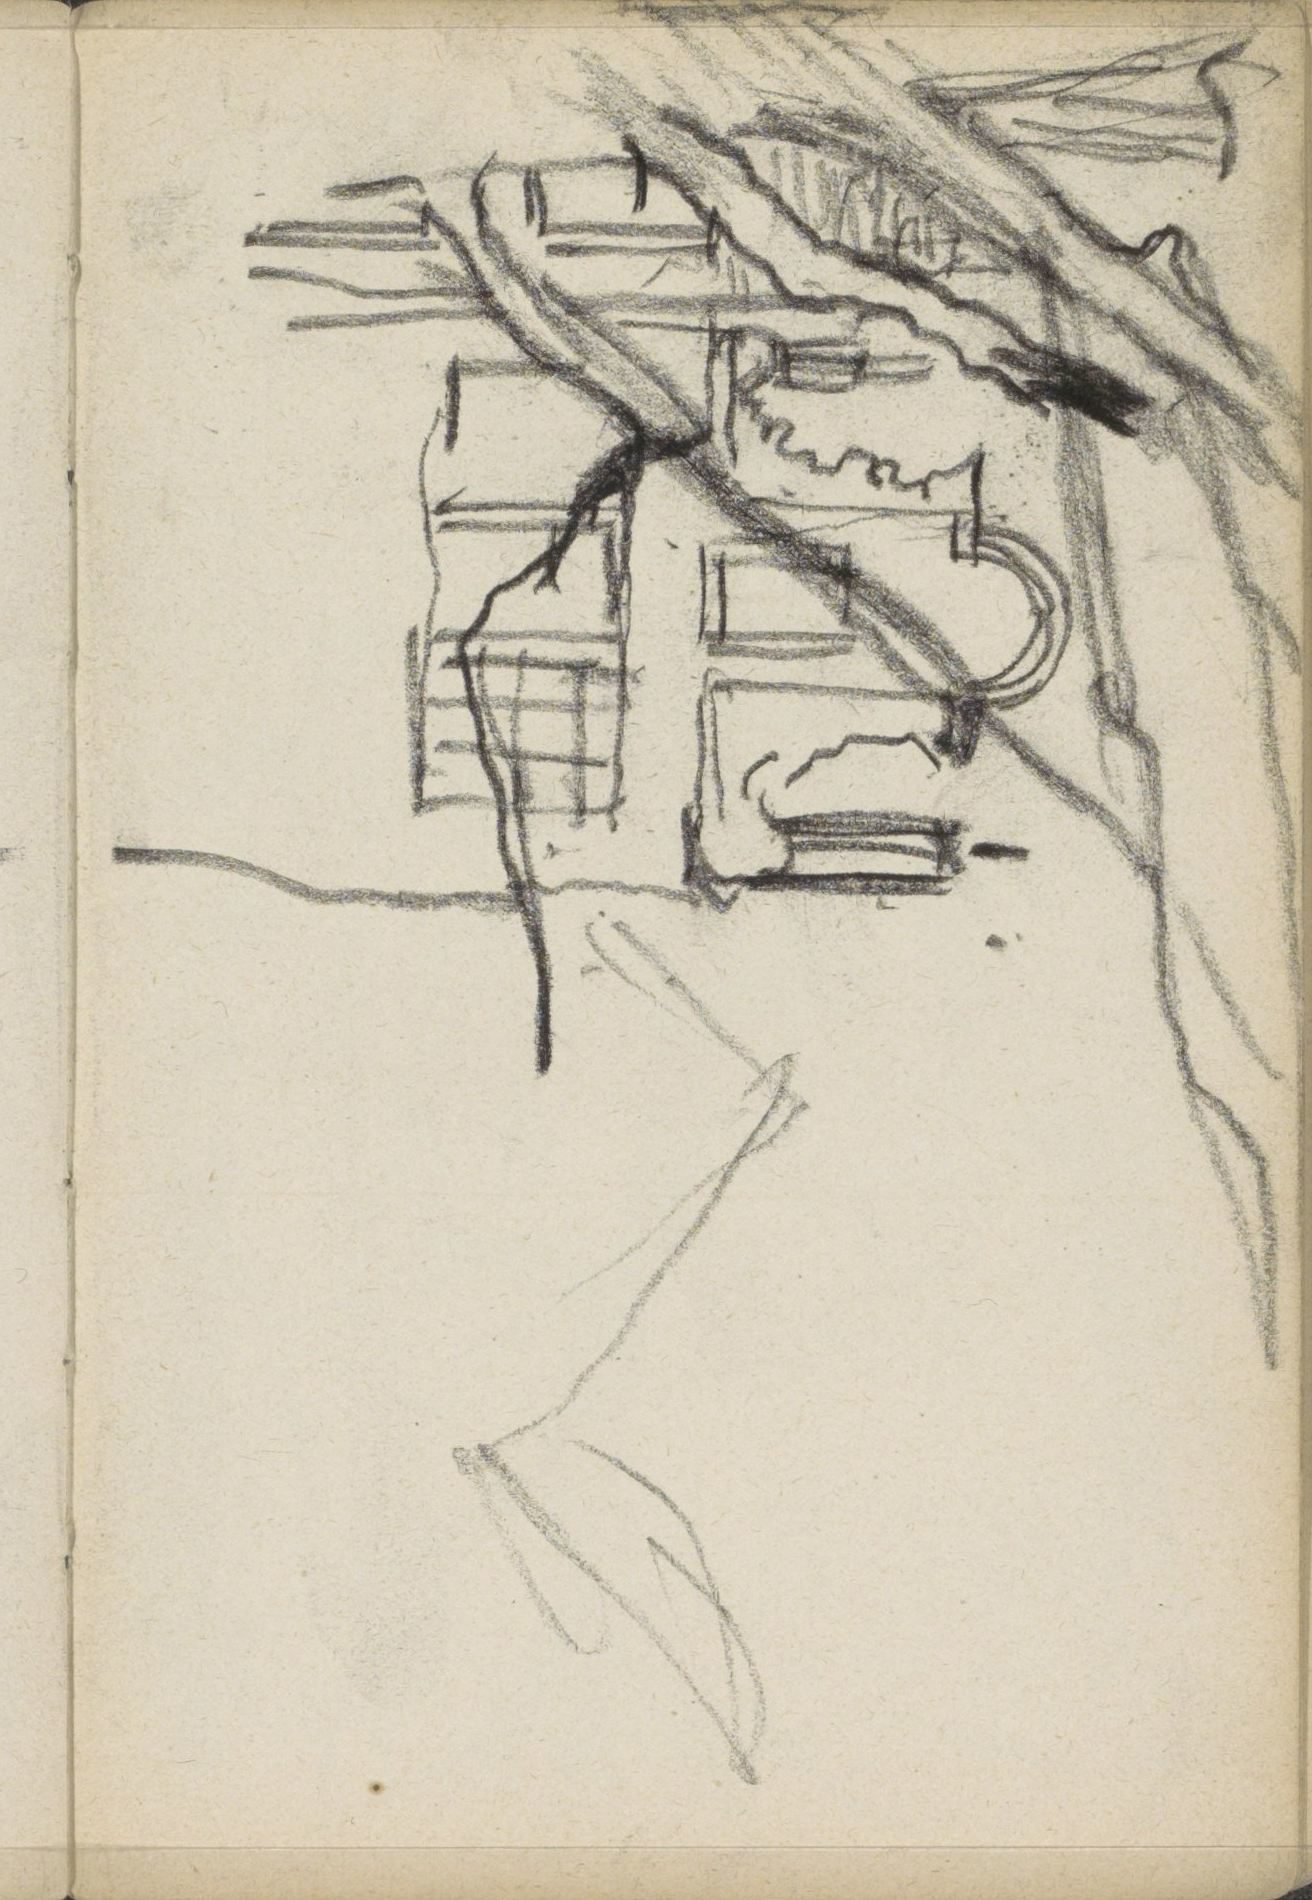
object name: sketchbook leaf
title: Gevels achter boomtakken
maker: george hendrik breitner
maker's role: draughtsman, painter, print maker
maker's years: 1857-1923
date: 1900-1901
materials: chalk, paper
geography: amsterdam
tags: trees (+ branch, stick), façade (of house or building)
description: Gevels achter boomtakken. Pagina 64 uit een schetsboek met 46 bladen vervaardigd te Amsterdam.